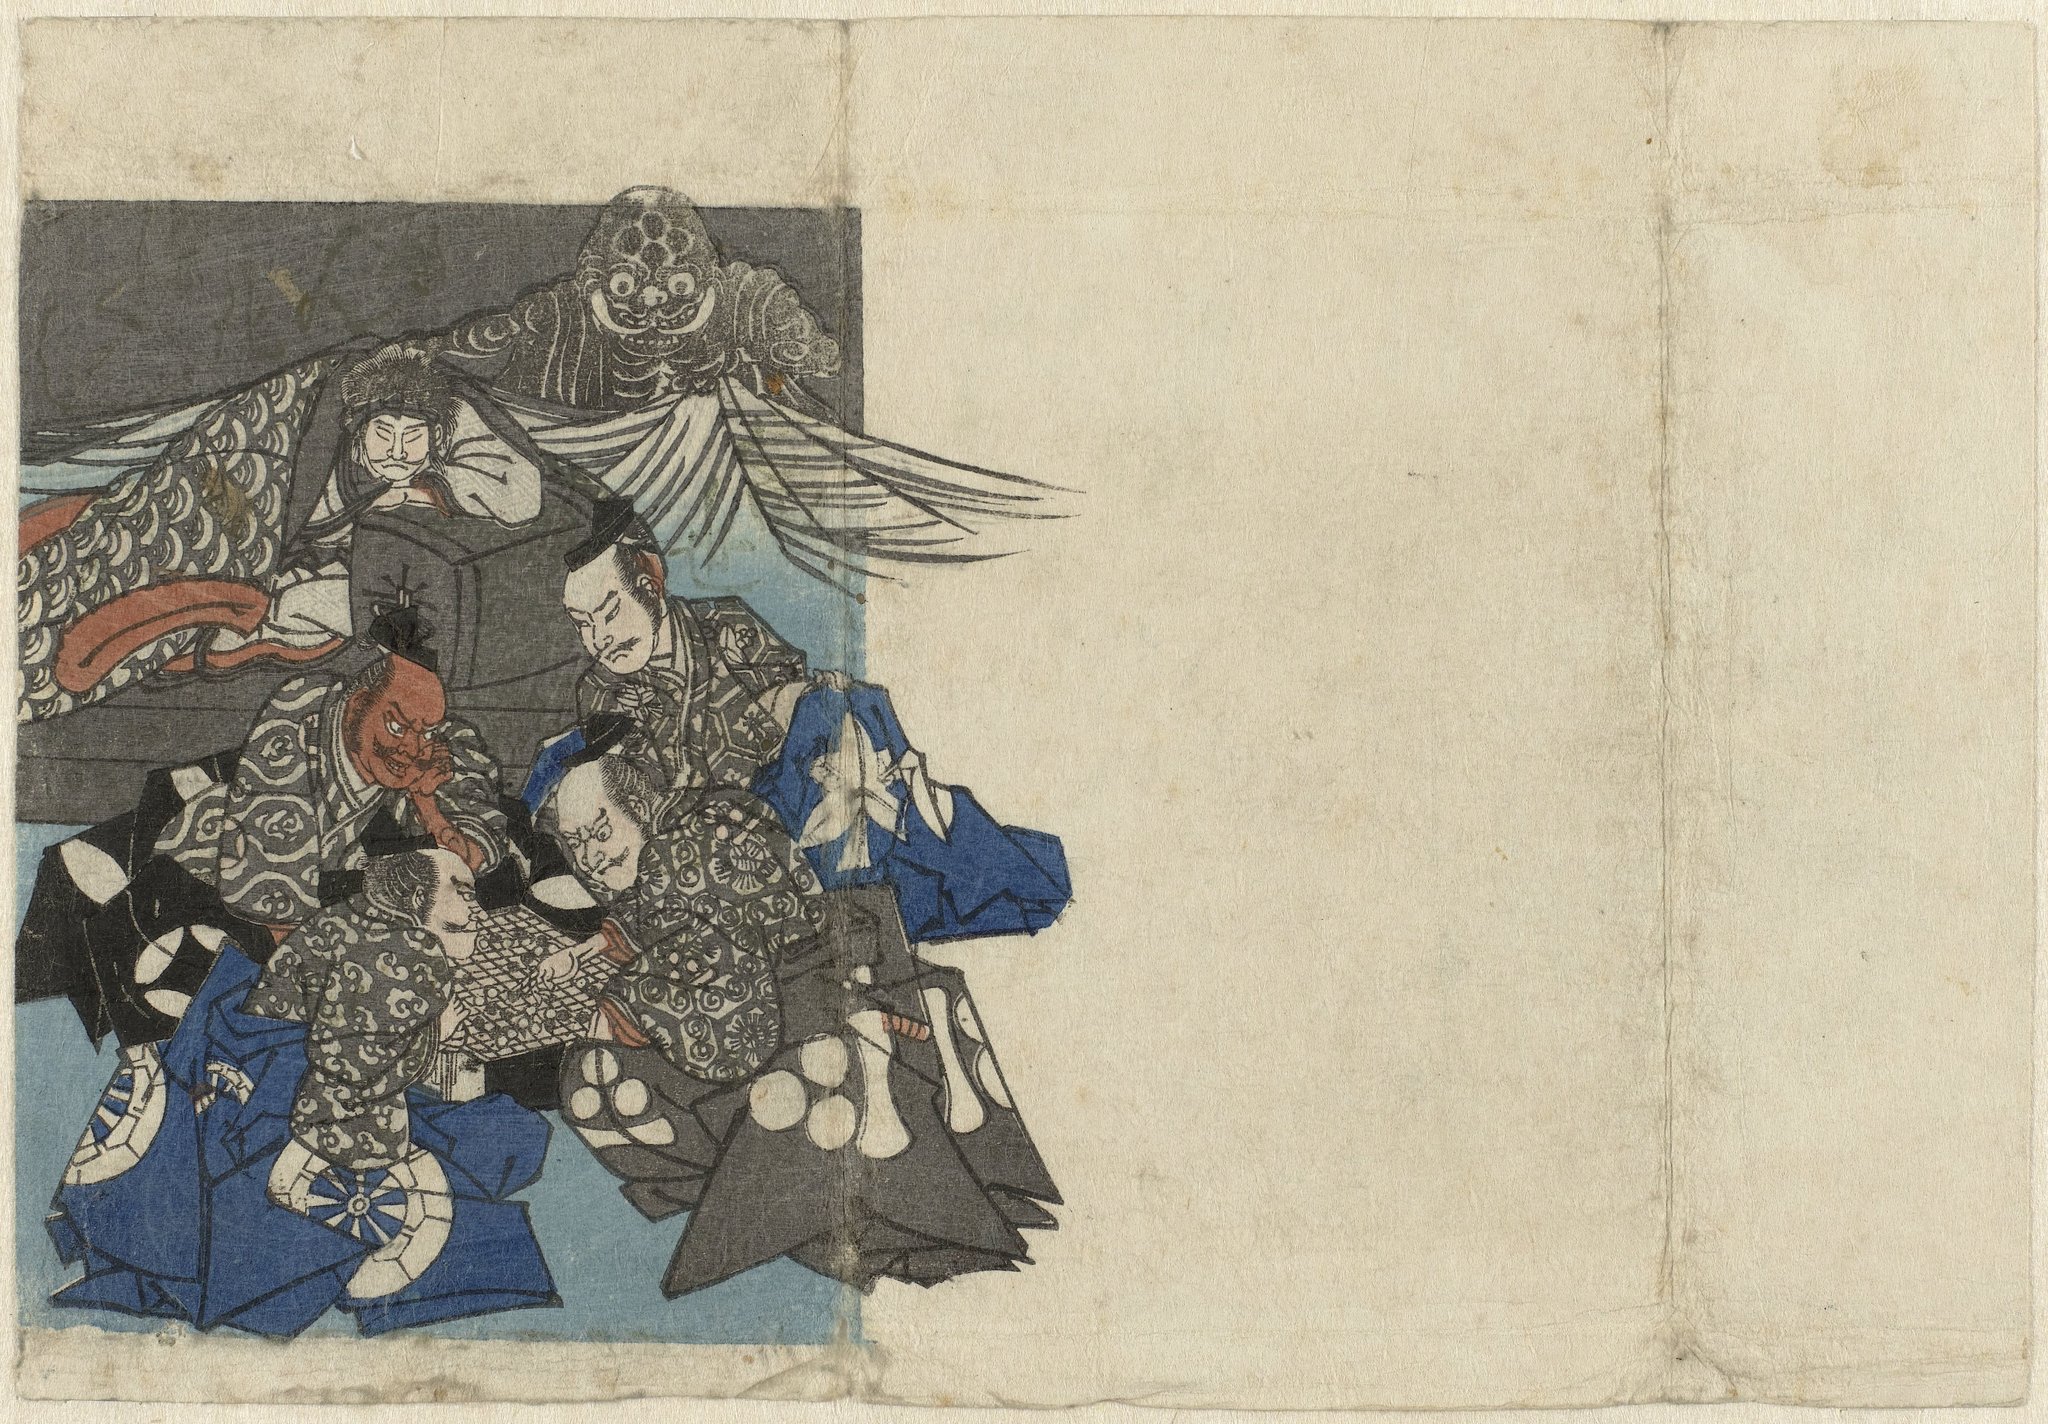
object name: wrapper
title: Raikô en de aardspin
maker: Anonymous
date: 1800-1899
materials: paper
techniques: woodcut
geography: japan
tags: board-games